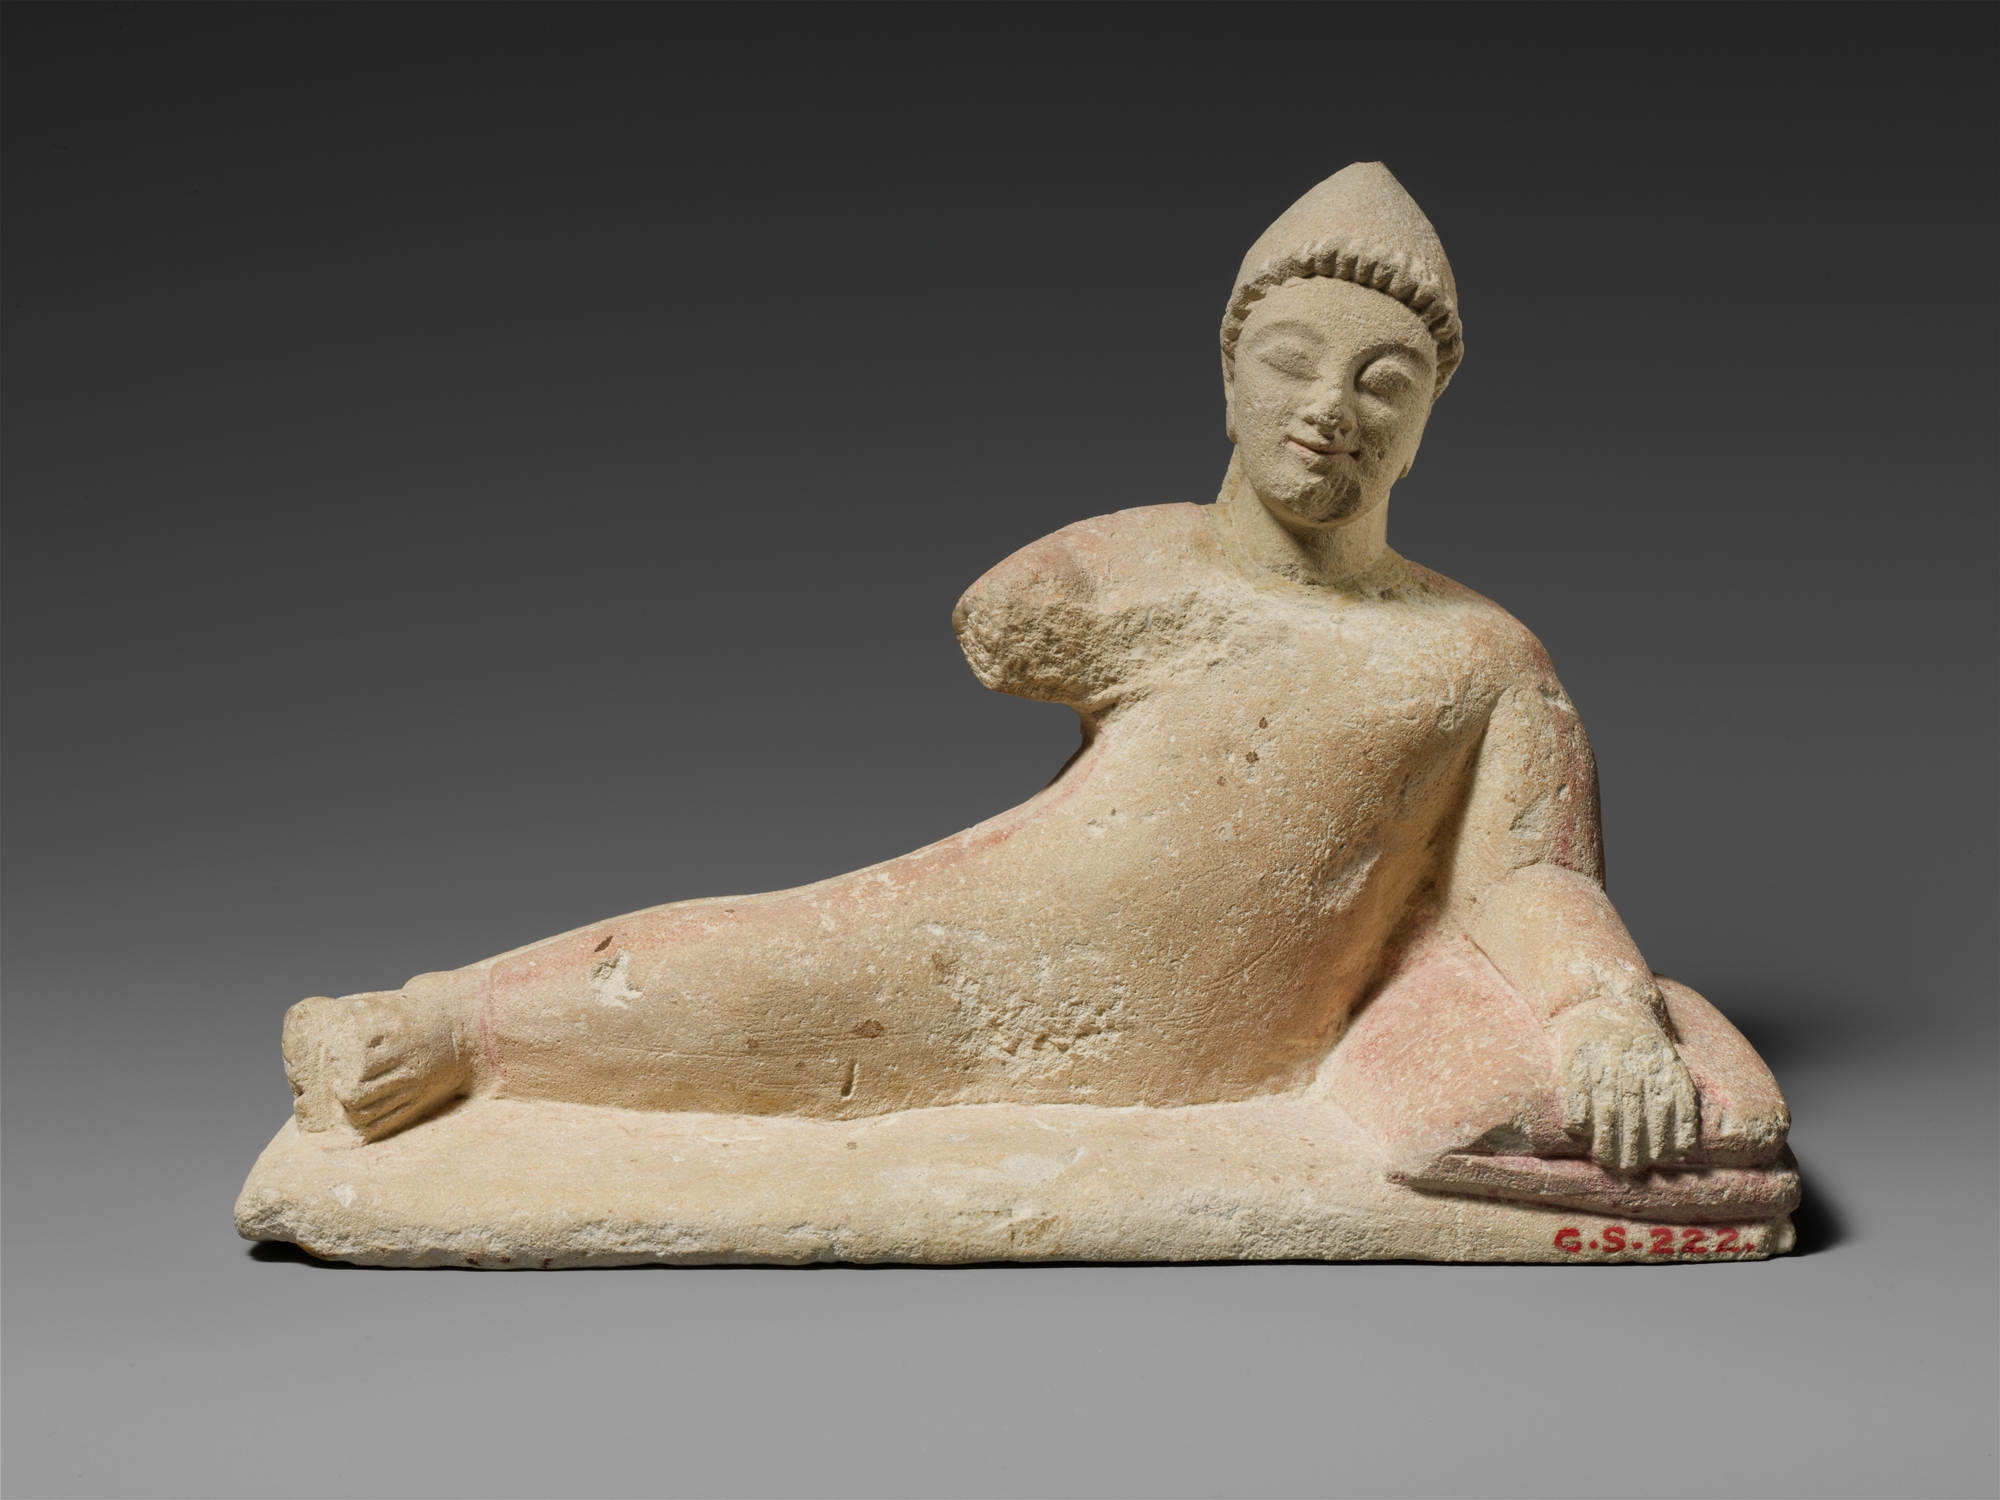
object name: statue of a votary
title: Limestone statuette of a recumbent votary (worshipper)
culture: cypriot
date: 600-501 BCE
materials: limestone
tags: men